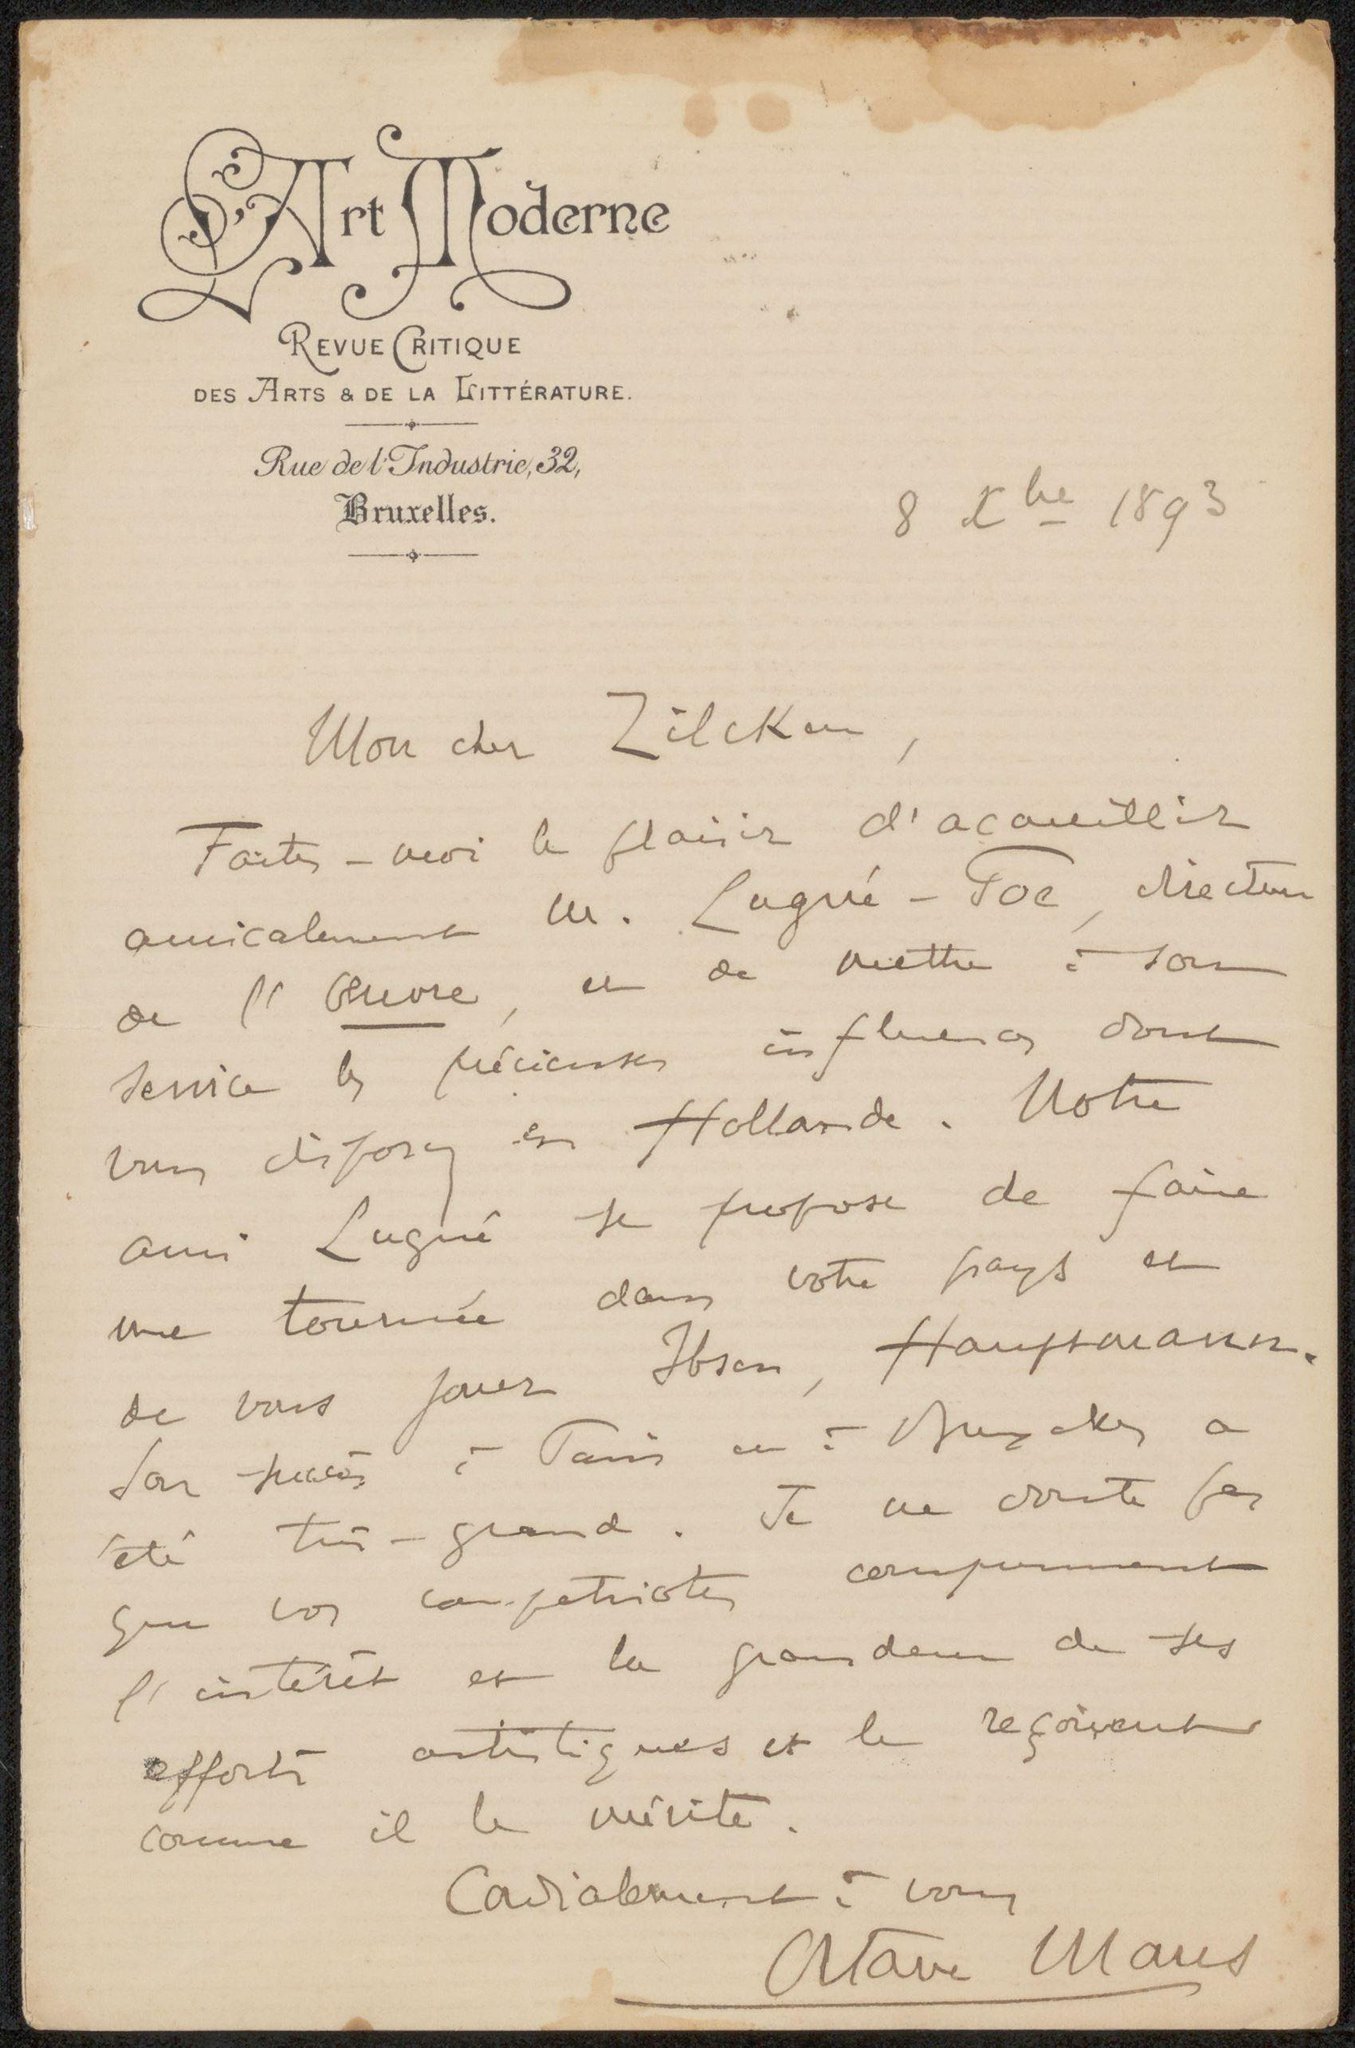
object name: letter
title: Brief aan Philip Zilcken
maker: octave maus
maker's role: painter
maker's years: 1856-1919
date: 1893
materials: ink, paper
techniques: pen, printing, writing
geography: brussels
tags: paris, lugné-poe, the hague, draughtsman, philip zilcken, the arts of the stage: ballet, theatre, musical drama, motion picture, netherlands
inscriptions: collector's mark: ‘RPK’